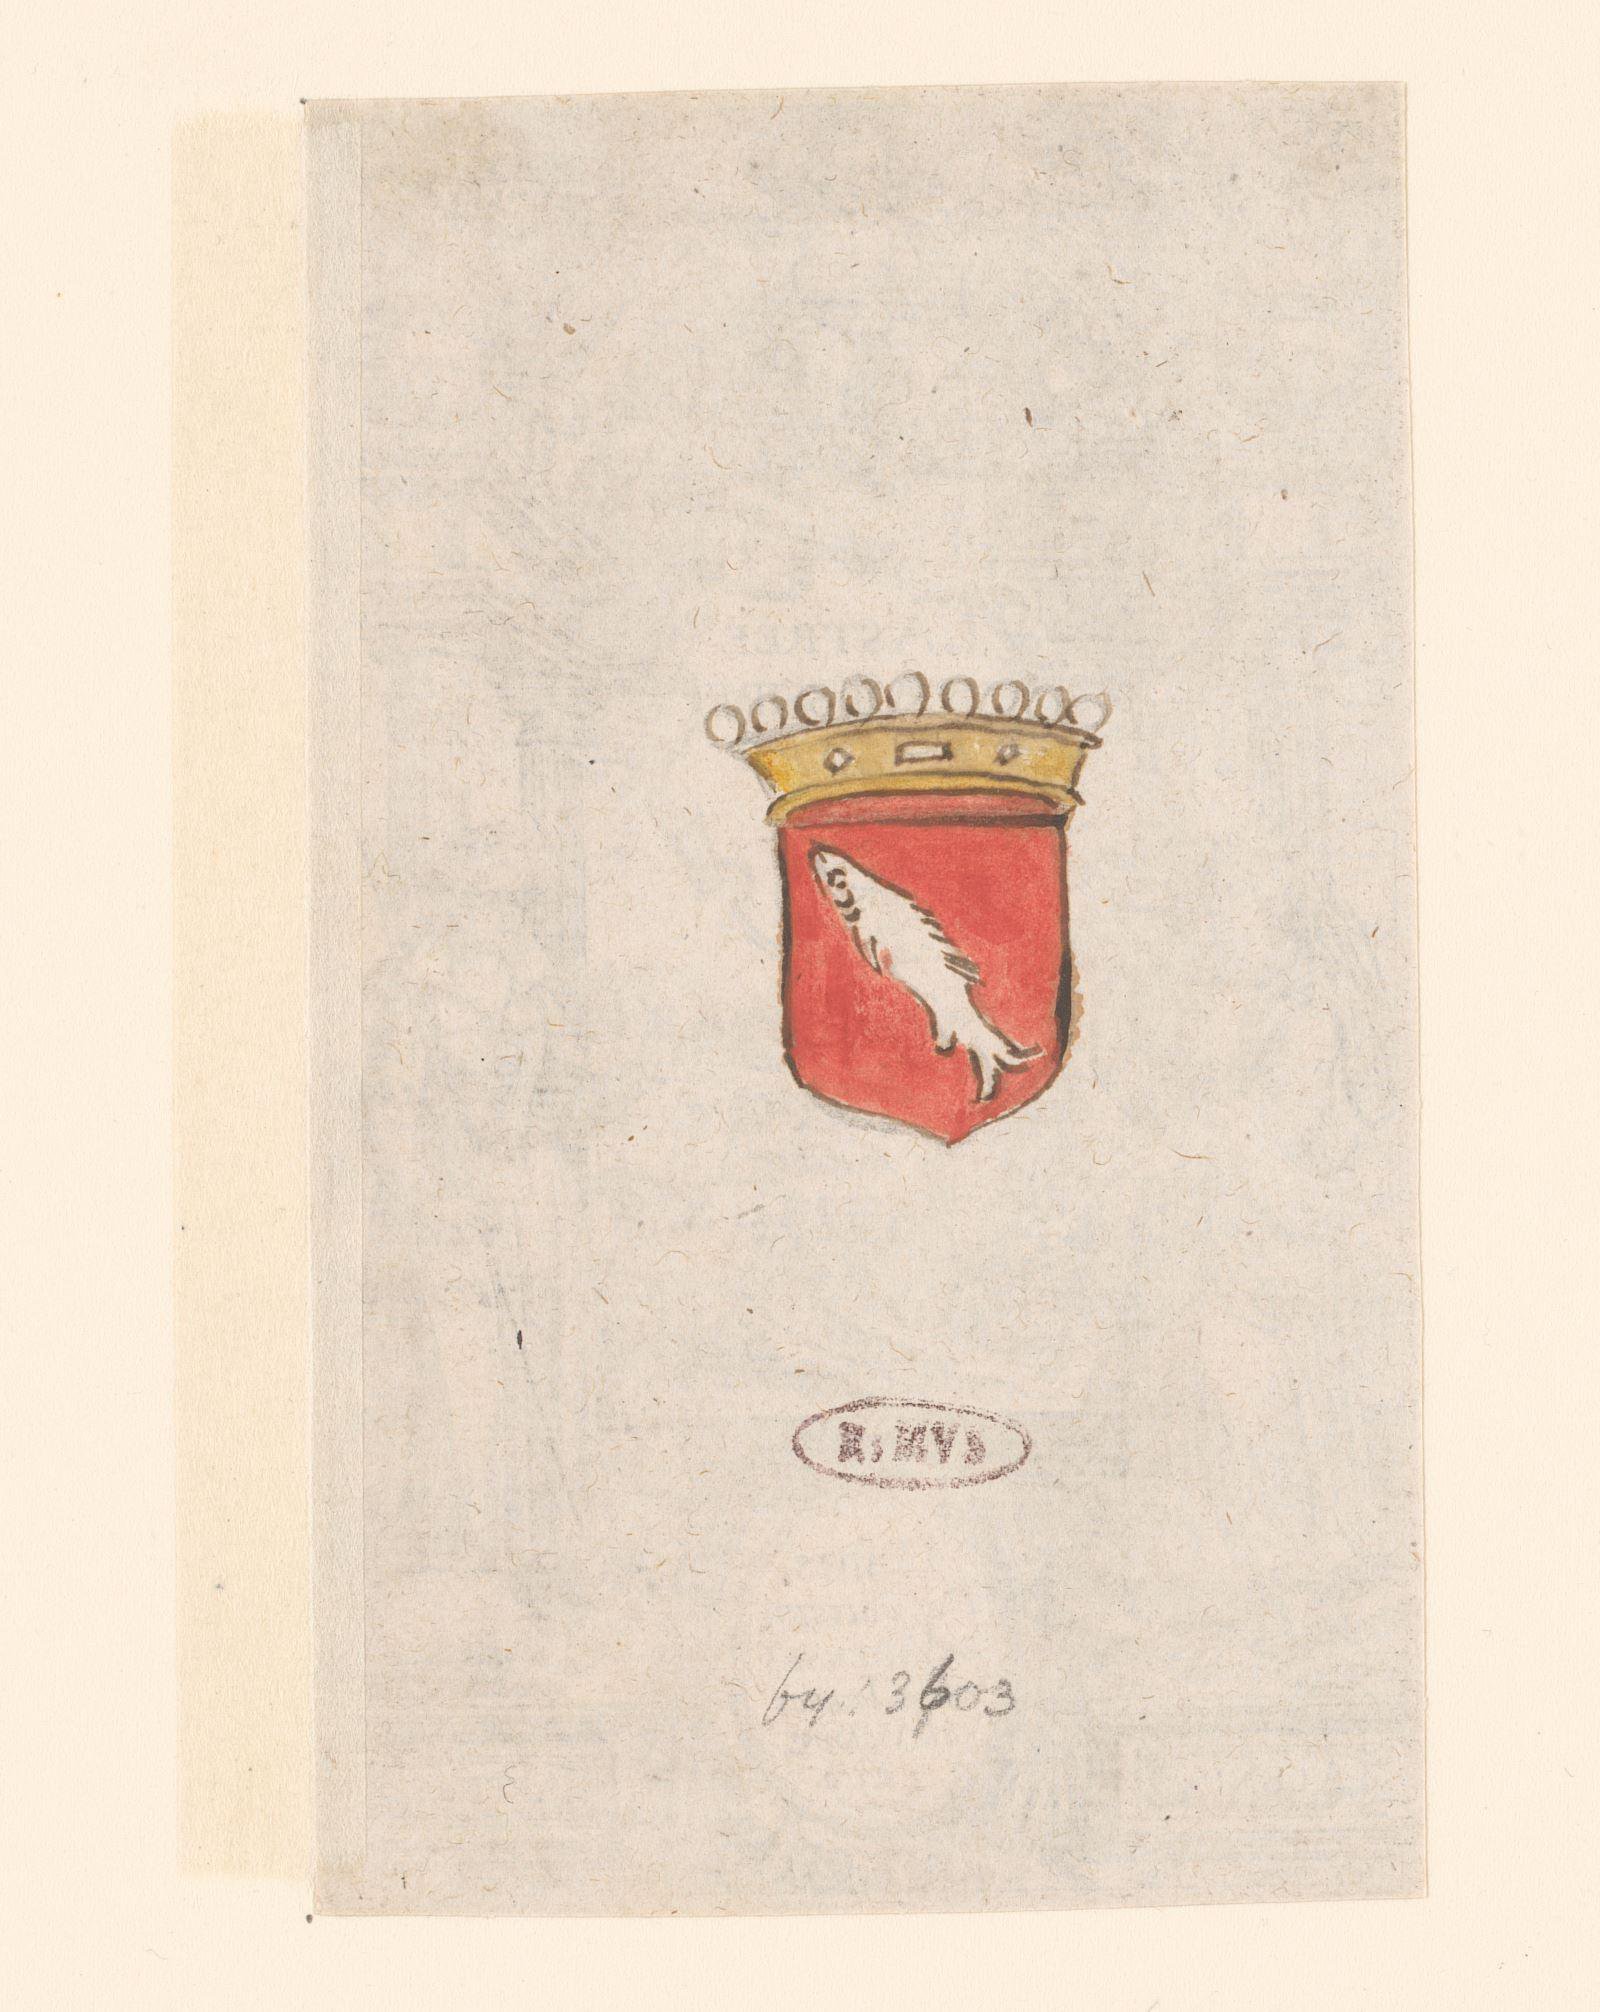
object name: drawing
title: Wapenschild met vis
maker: Anonymous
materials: ink, paper, watercolor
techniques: brush, pen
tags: fishes, armorial bearing, heraldry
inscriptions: collector's mark: Lugt 2228